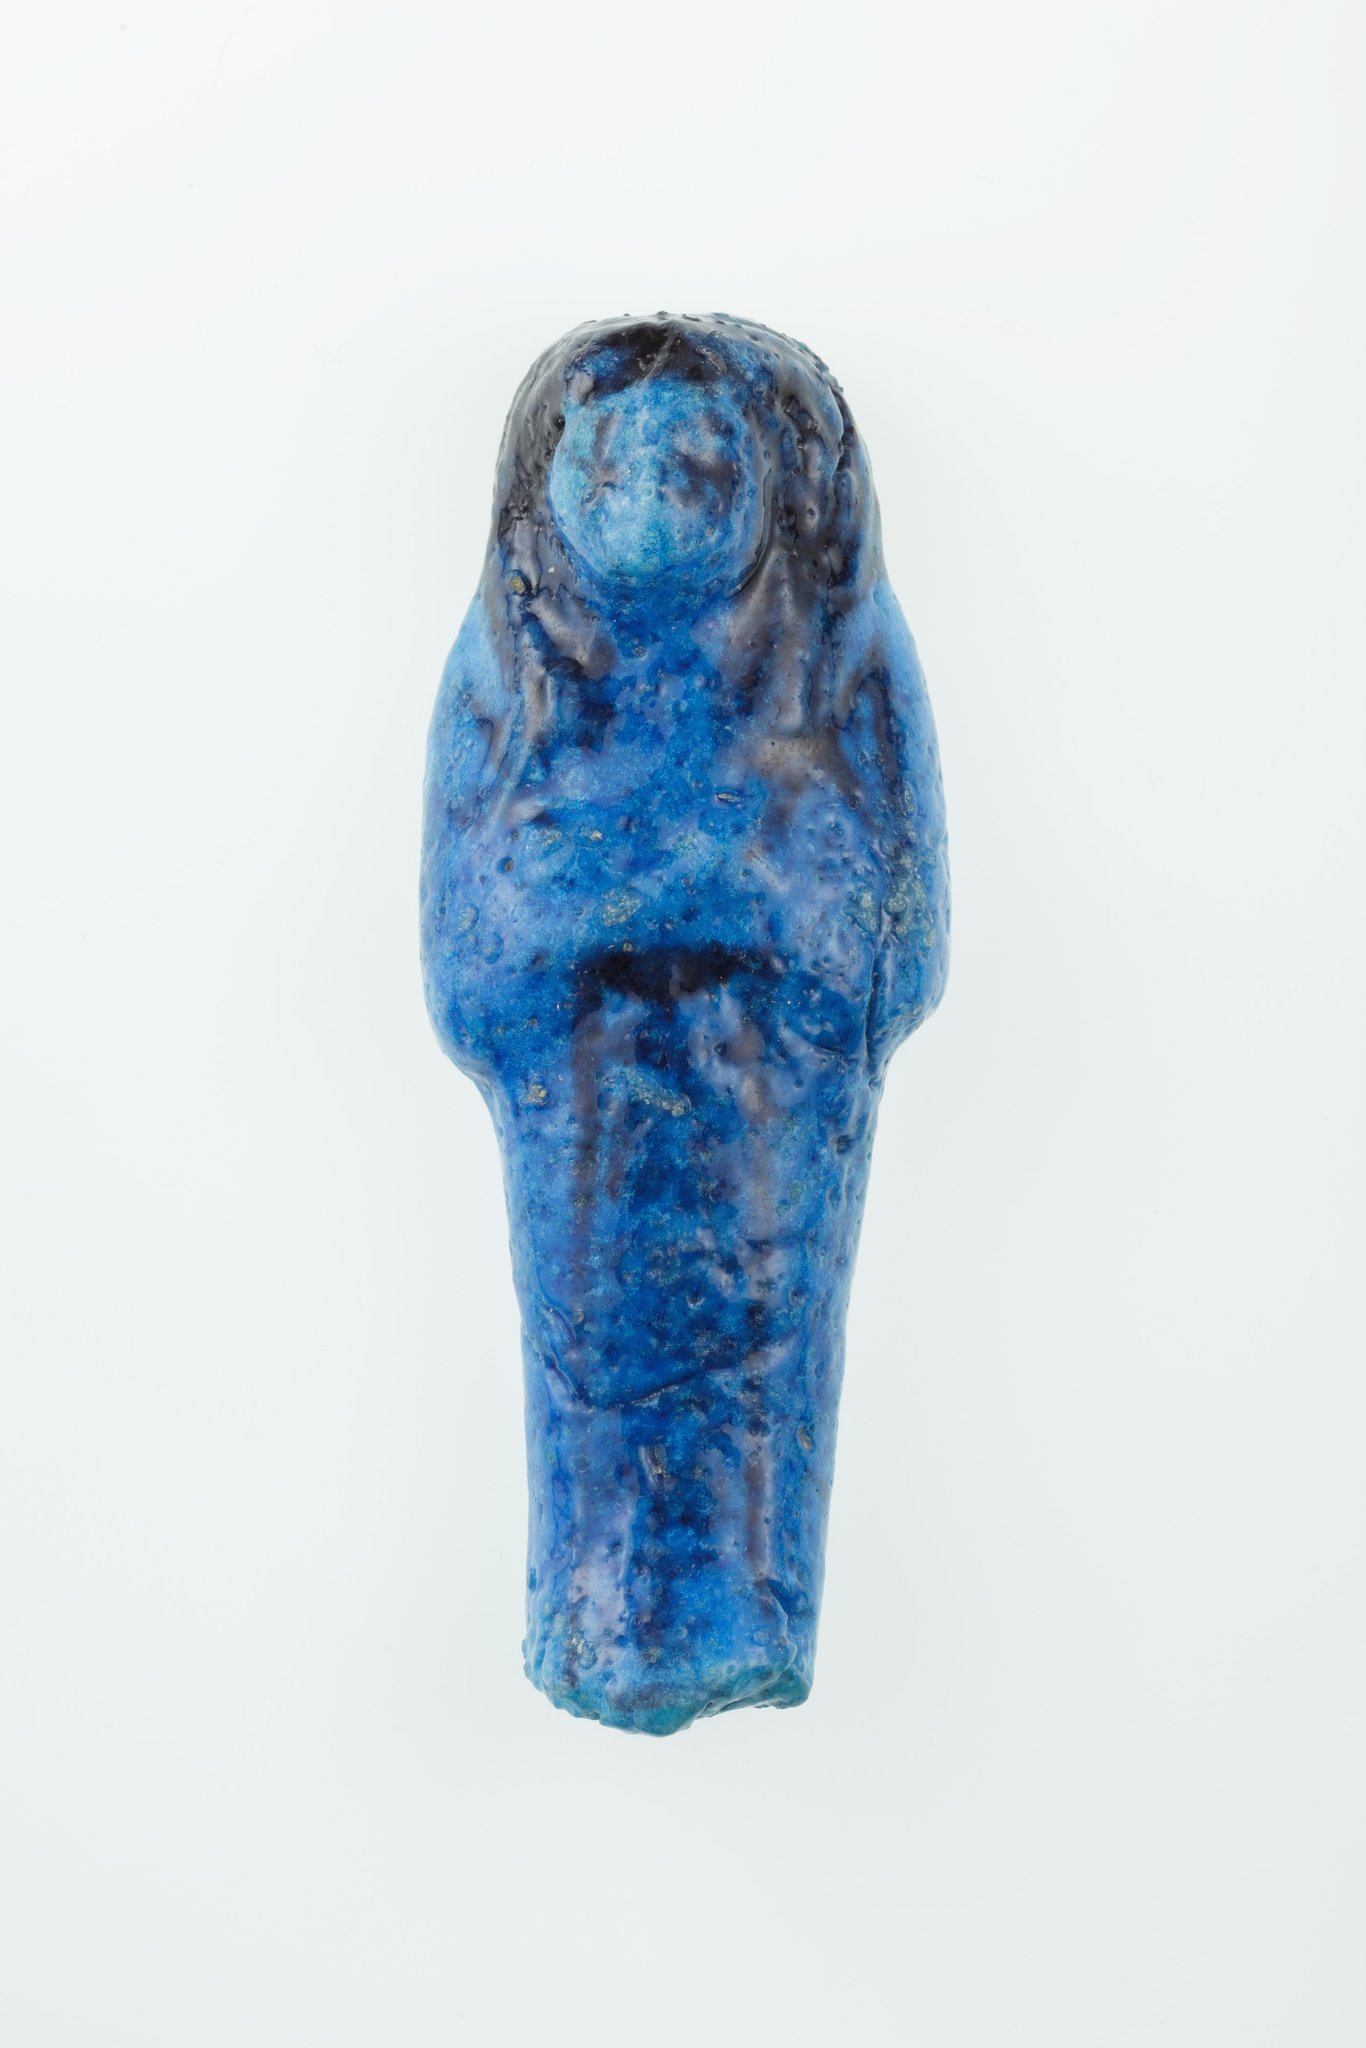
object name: shabti, worker, nauny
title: Worker Shabti of Nauny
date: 1050 BCE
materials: faience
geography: egypt